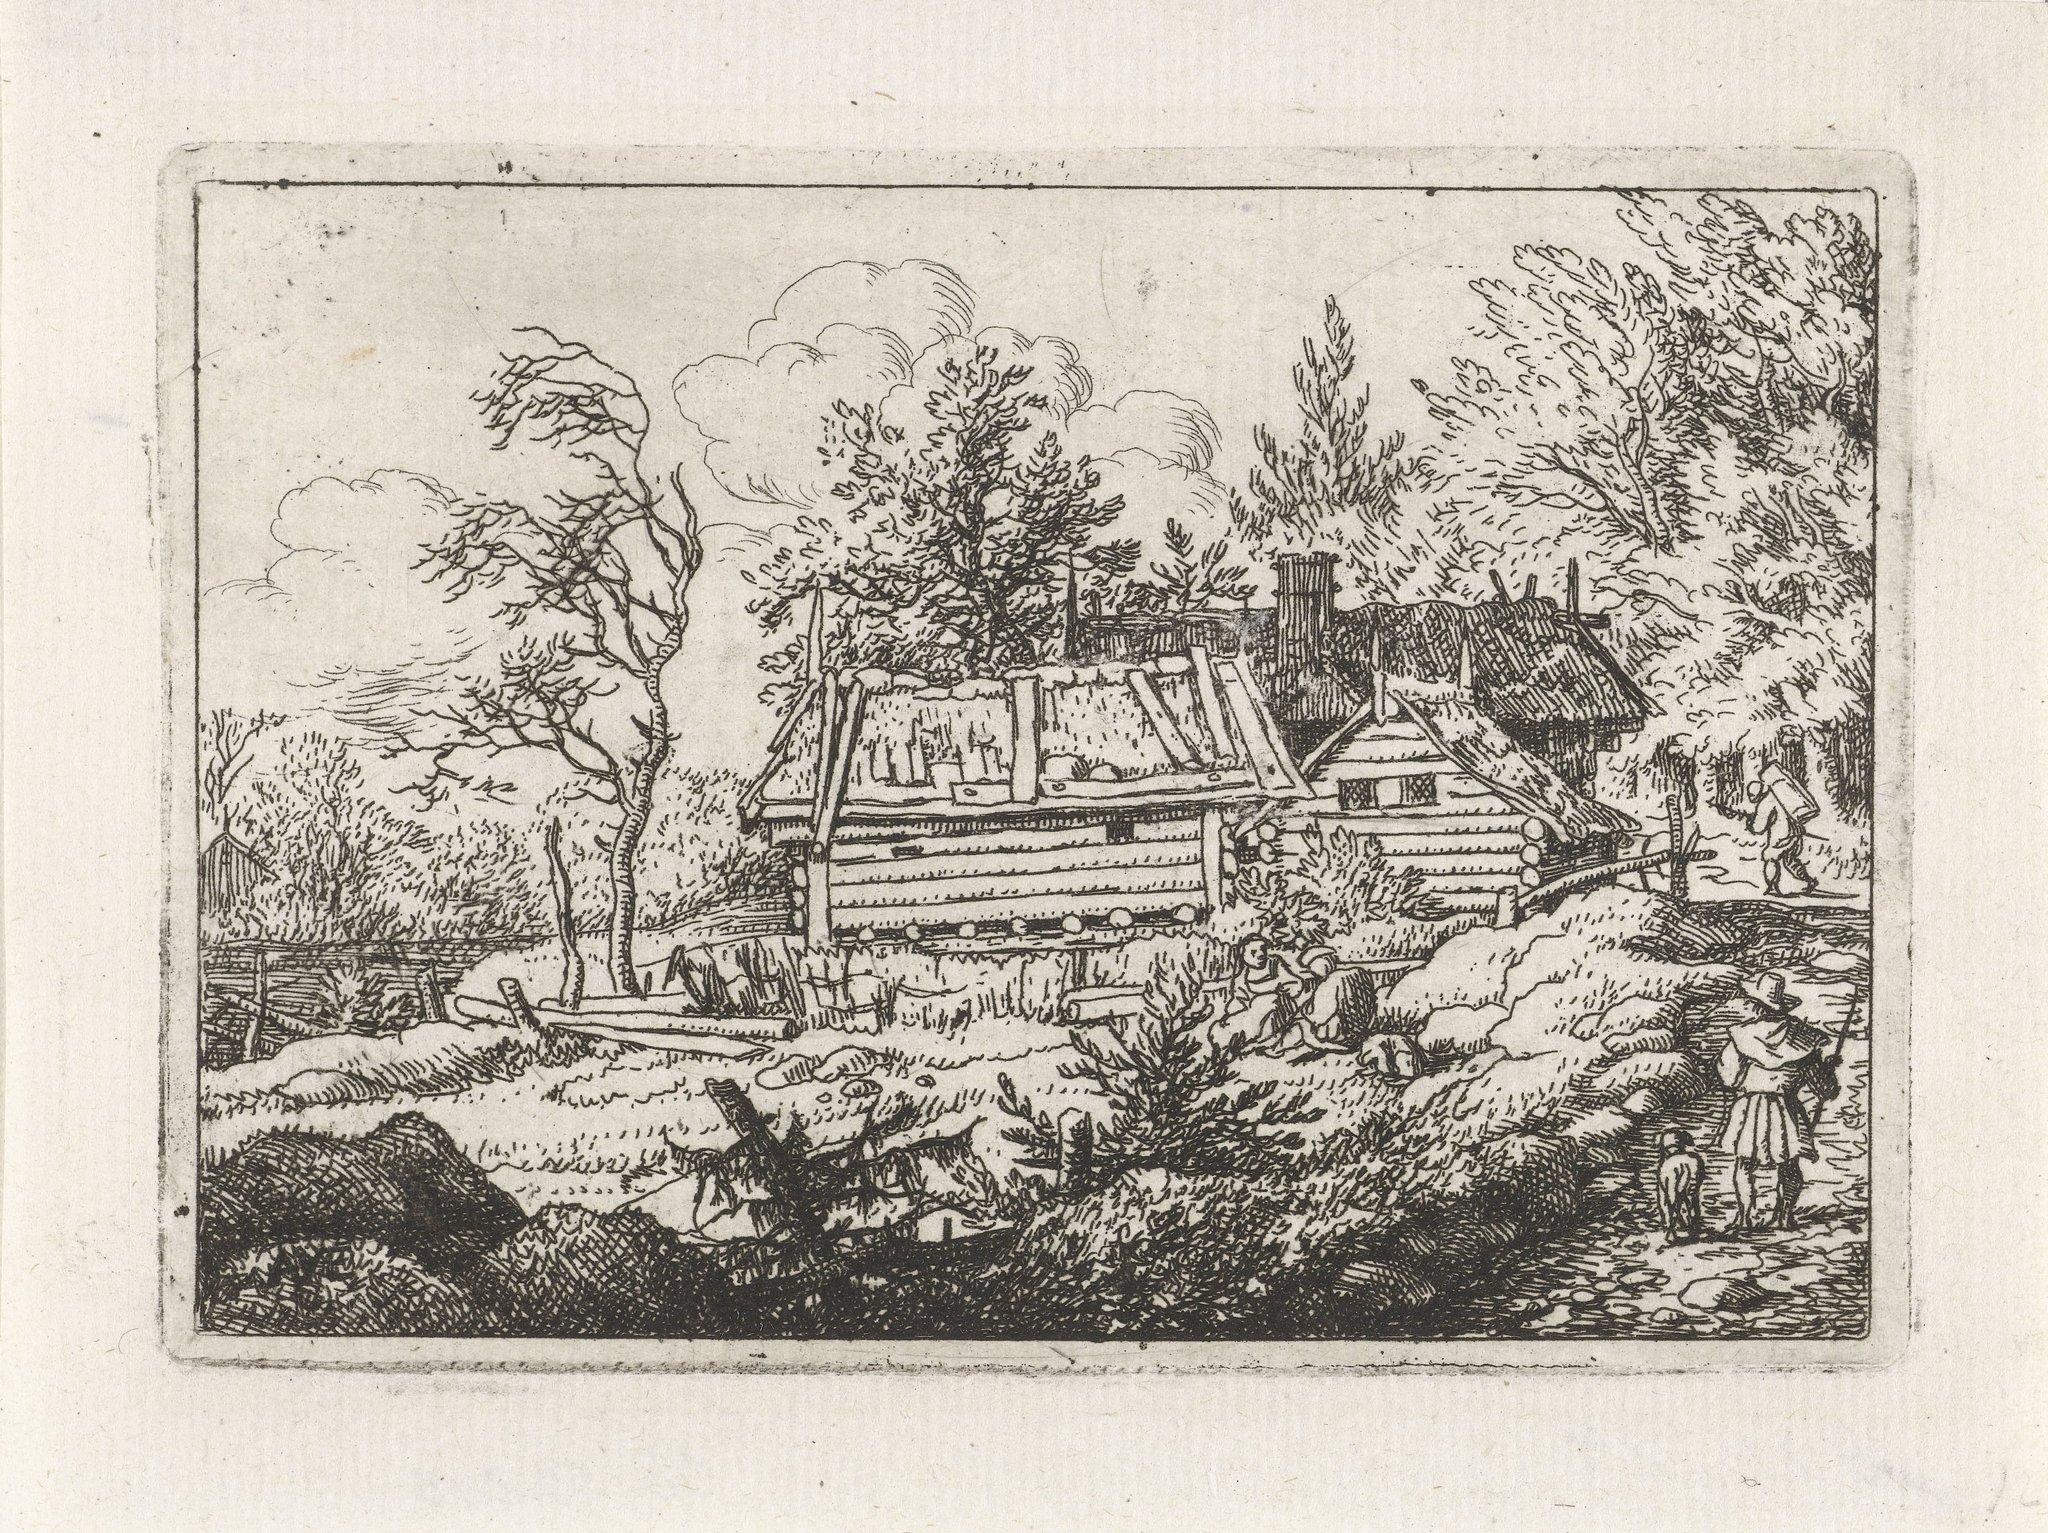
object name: print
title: Pelgrim met een hond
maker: allaert van everdingen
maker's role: draughtsman, painter, print maker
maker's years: 1621-1675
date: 1631-1675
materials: paper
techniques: etching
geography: netherlands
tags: farm or solitary house in landscape (+ city(-scape) with figures, staffage)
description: Landschap met drie houten gebouwen. Op het pad op de voorgrond een wandelaar met een hond. In het veld naast het pad twee zittende figuren.